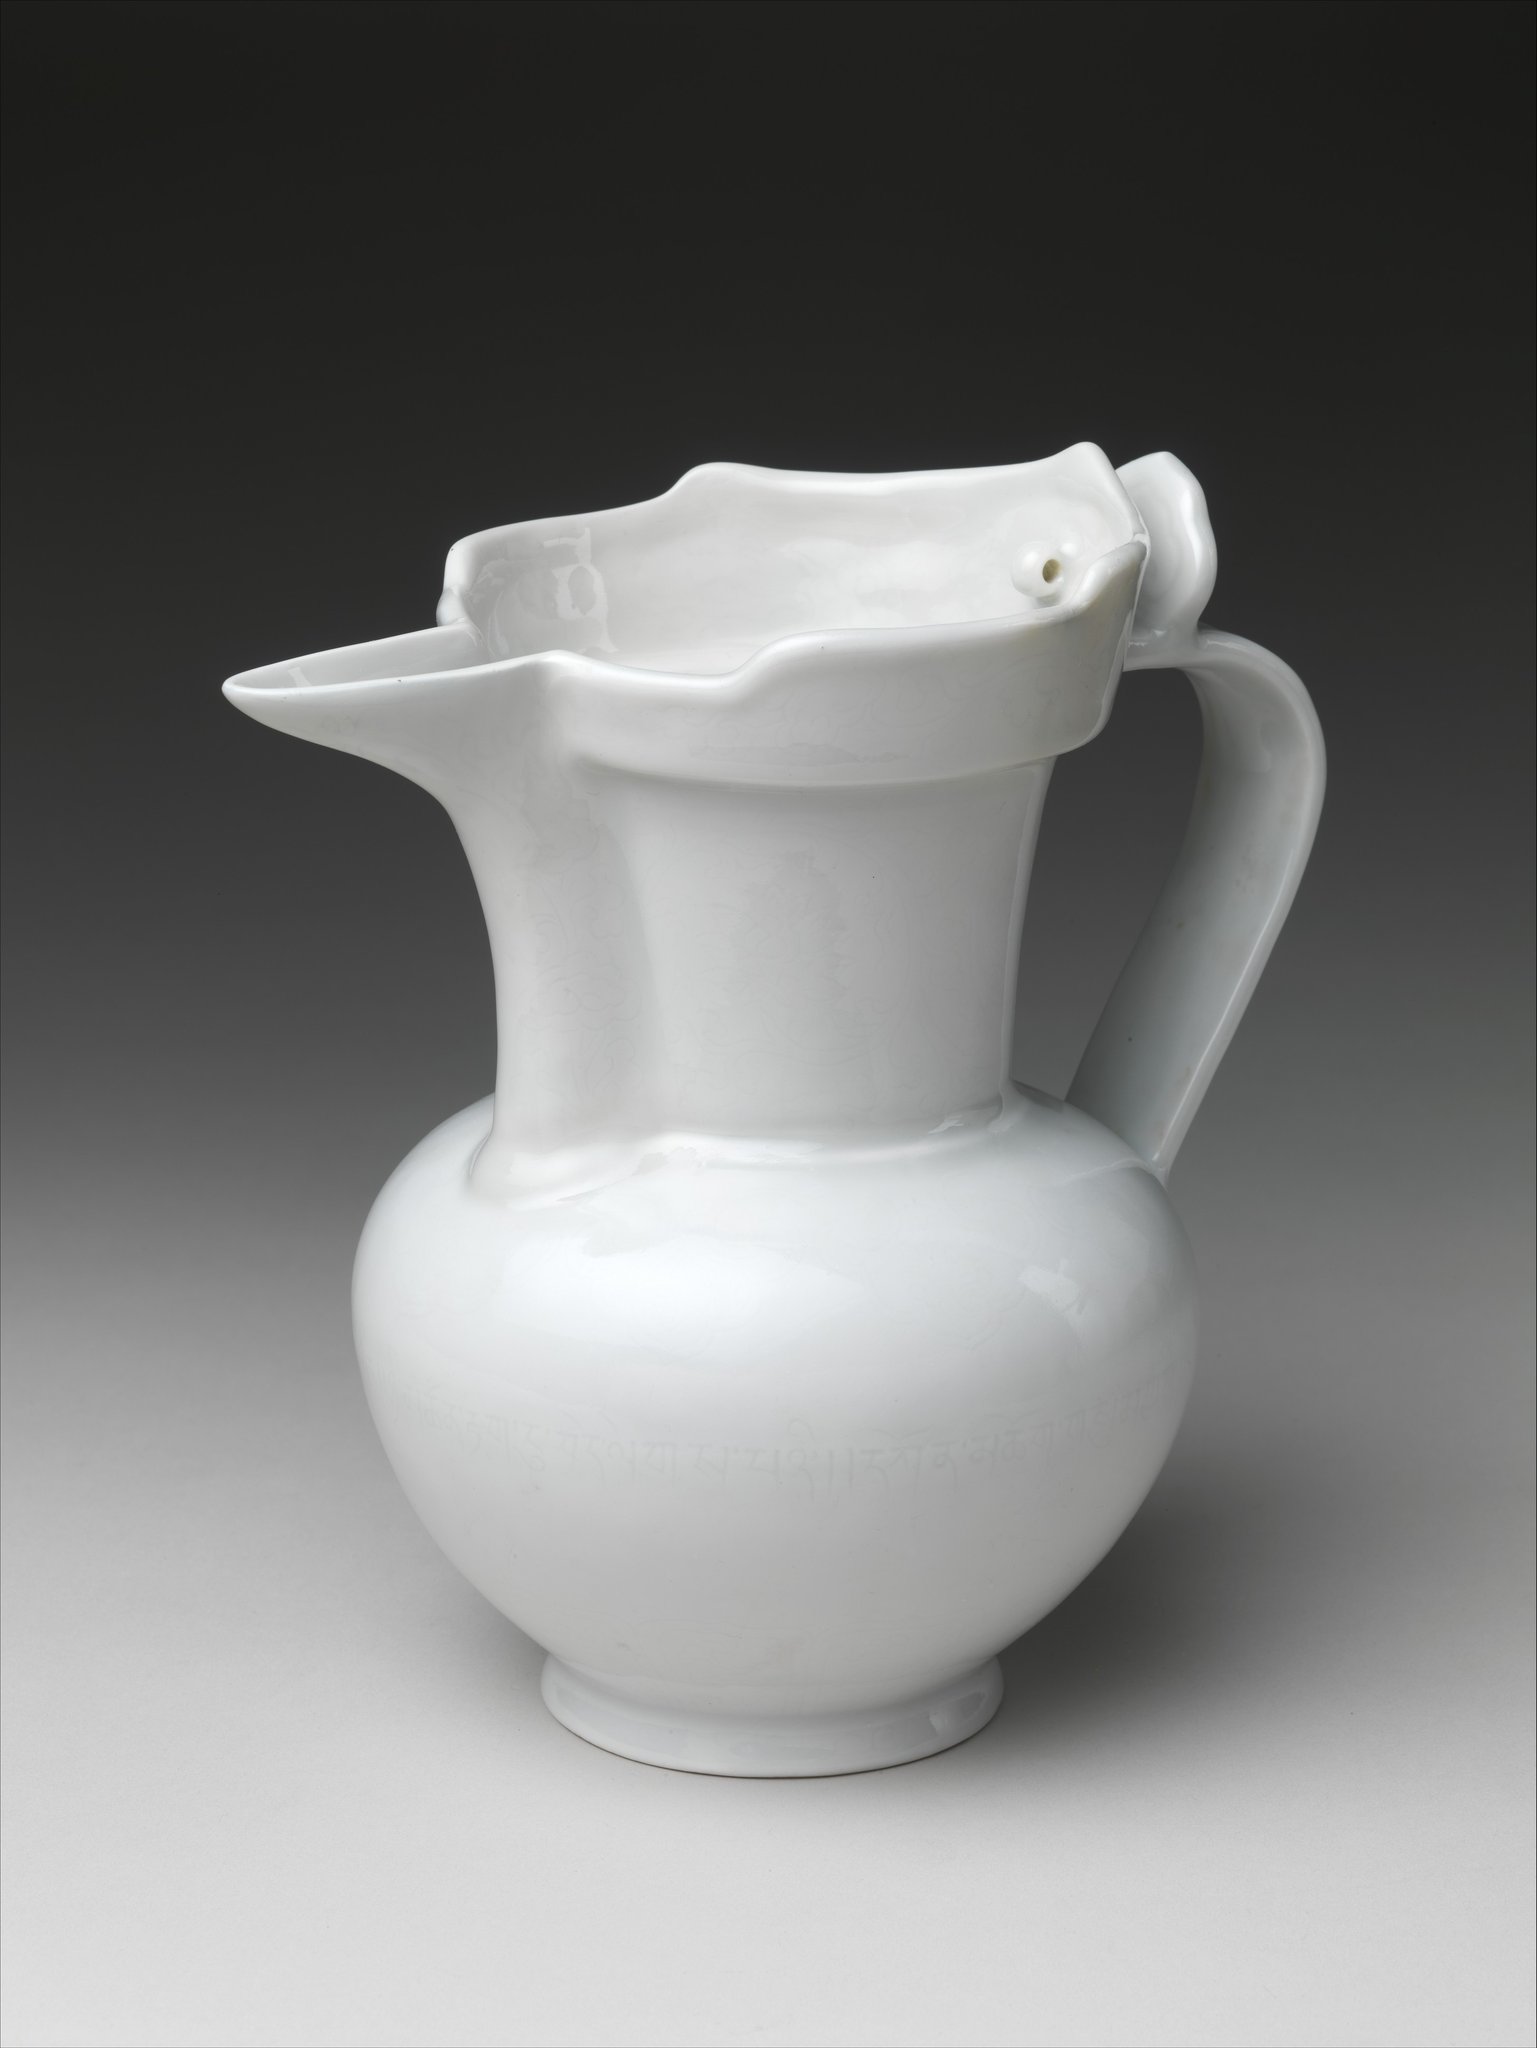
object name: ewer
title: Monk’s cap ewer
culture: chinese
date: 1401-1433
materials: glaze, porcelain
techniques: incising